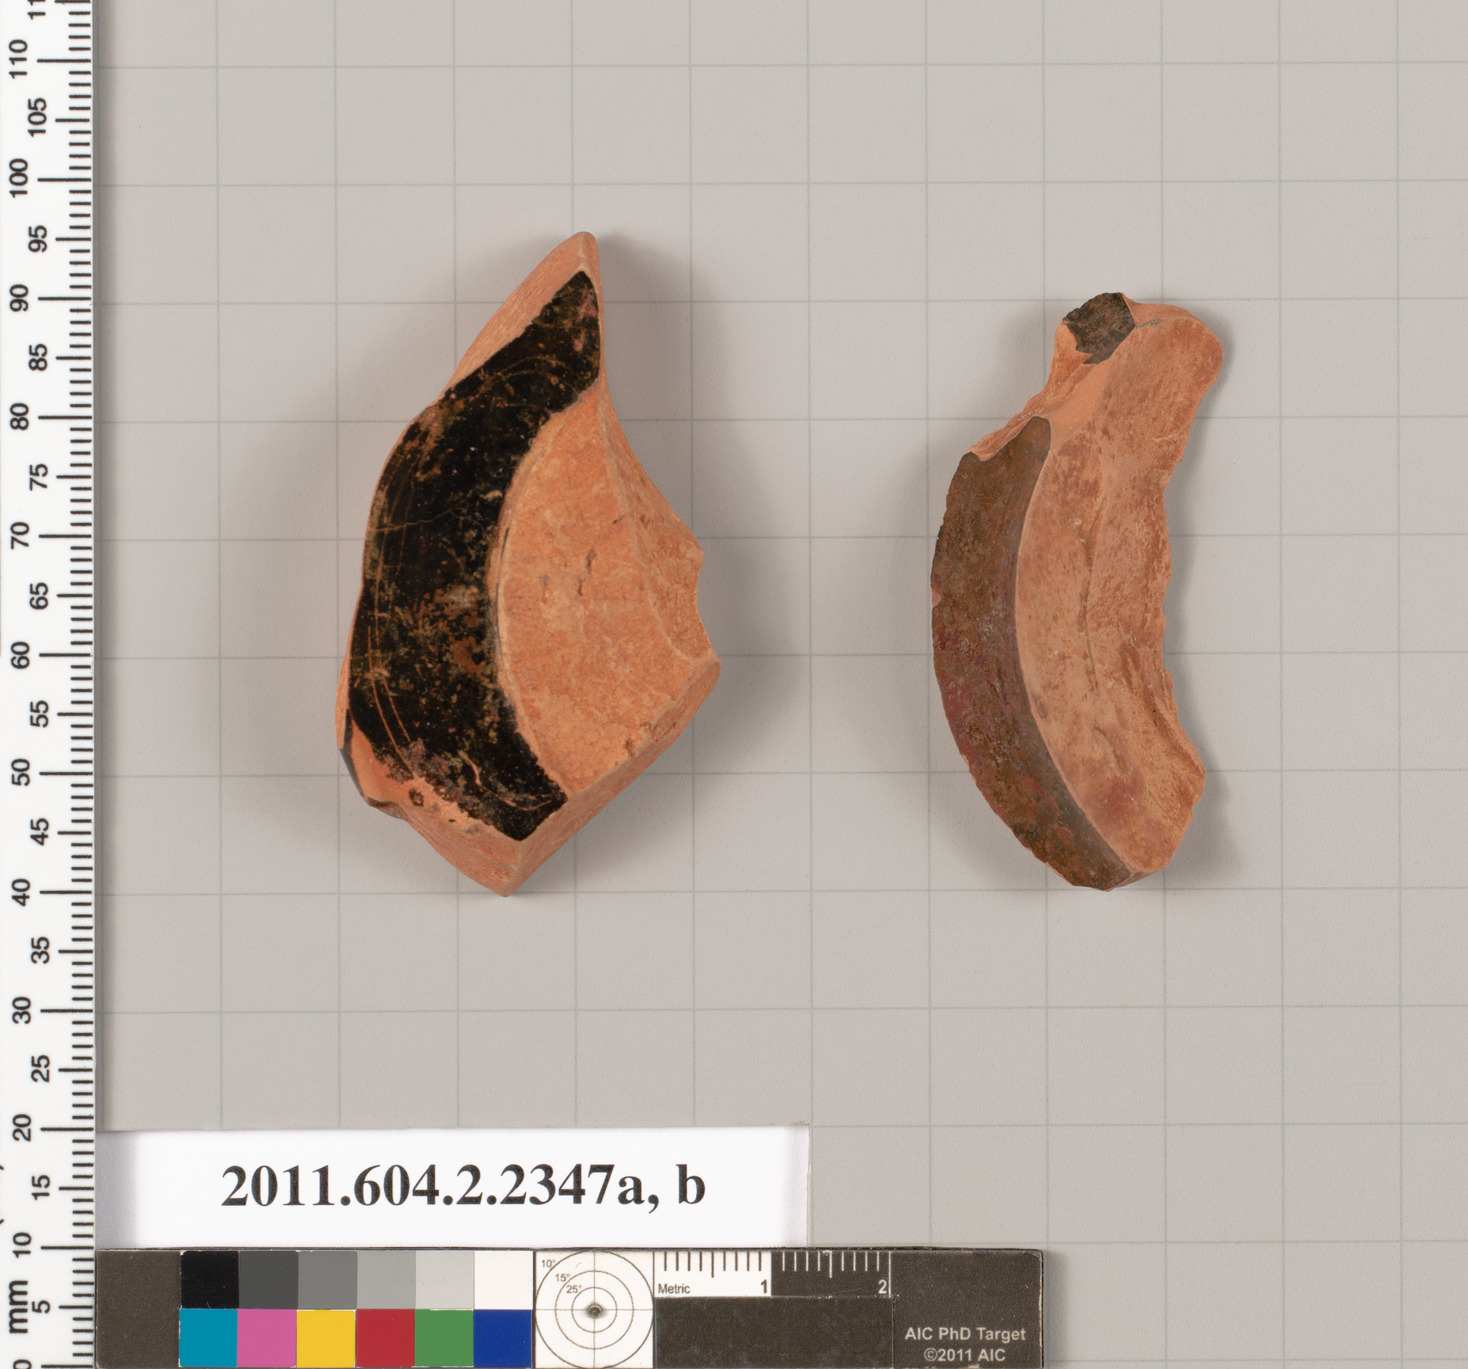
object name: lekythos fragment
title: Terracotta fragments of a lekythos (oil flask)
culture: greek, attic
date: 600-401 BCE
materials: terracotta